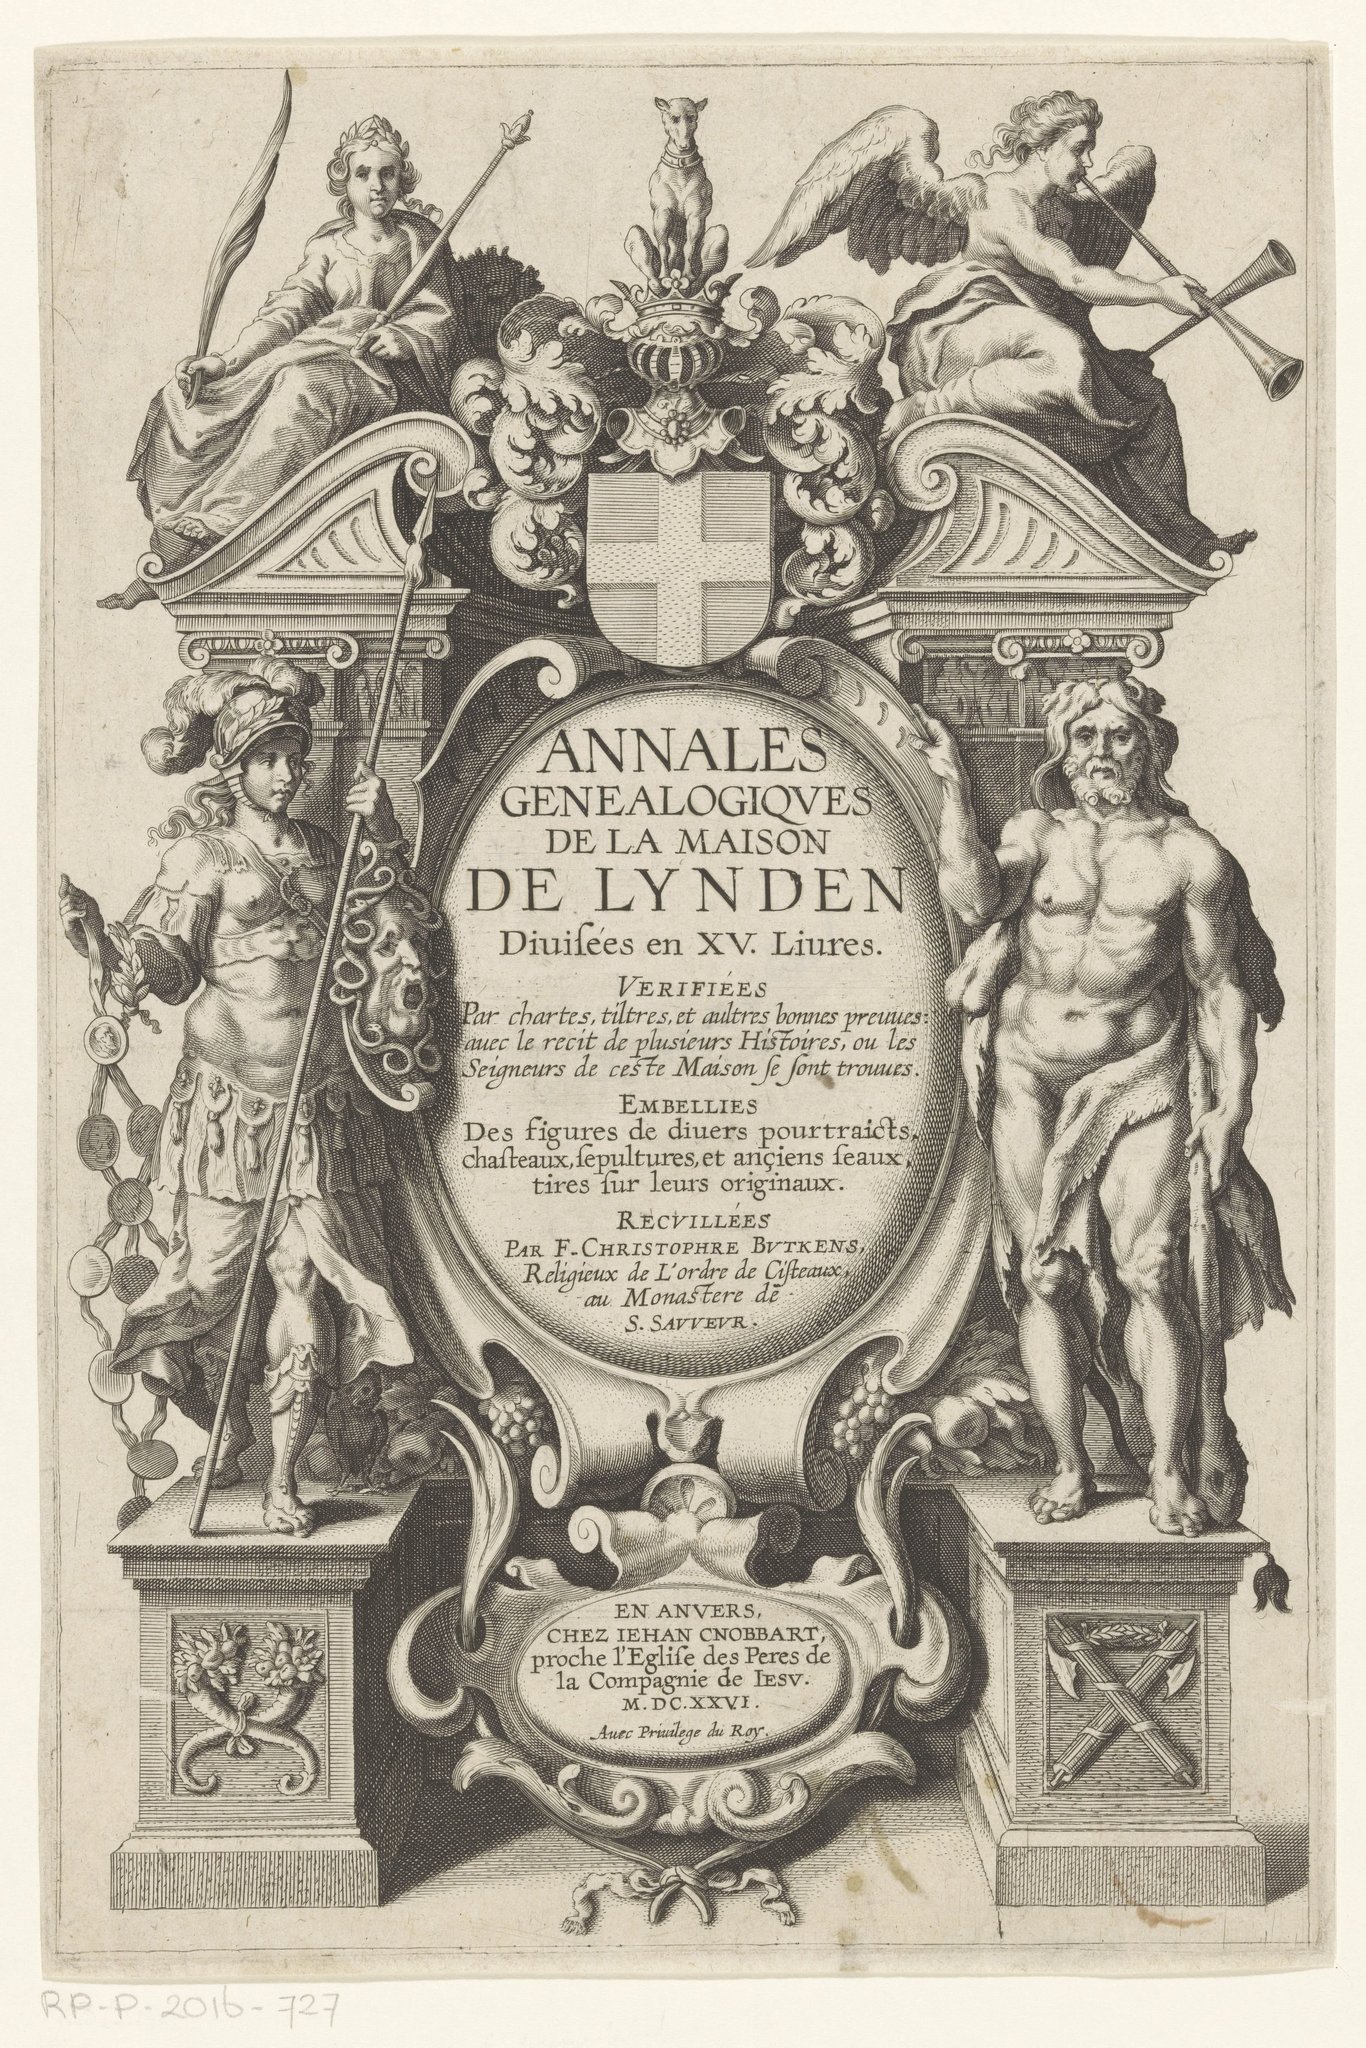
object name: print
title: Minerva en Hercules en stamwapen Van Lynden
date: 1626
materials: paper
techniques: engraving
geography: antwerp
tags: (story of) hercules (heracles), (story of) minerva (pallas, athena), armorial bearing, heraldry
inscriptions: collector's mark: Lugt 240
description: Hercules met knots en leeuwenvel en Minerva met speer en schild met Medusakop en een lint met portretten of zegels flankeren een cartouche met titel. Daarboven het stamwapen van het geslacht Van Lynden met een vrouw met palmtak en scepter en Fama.